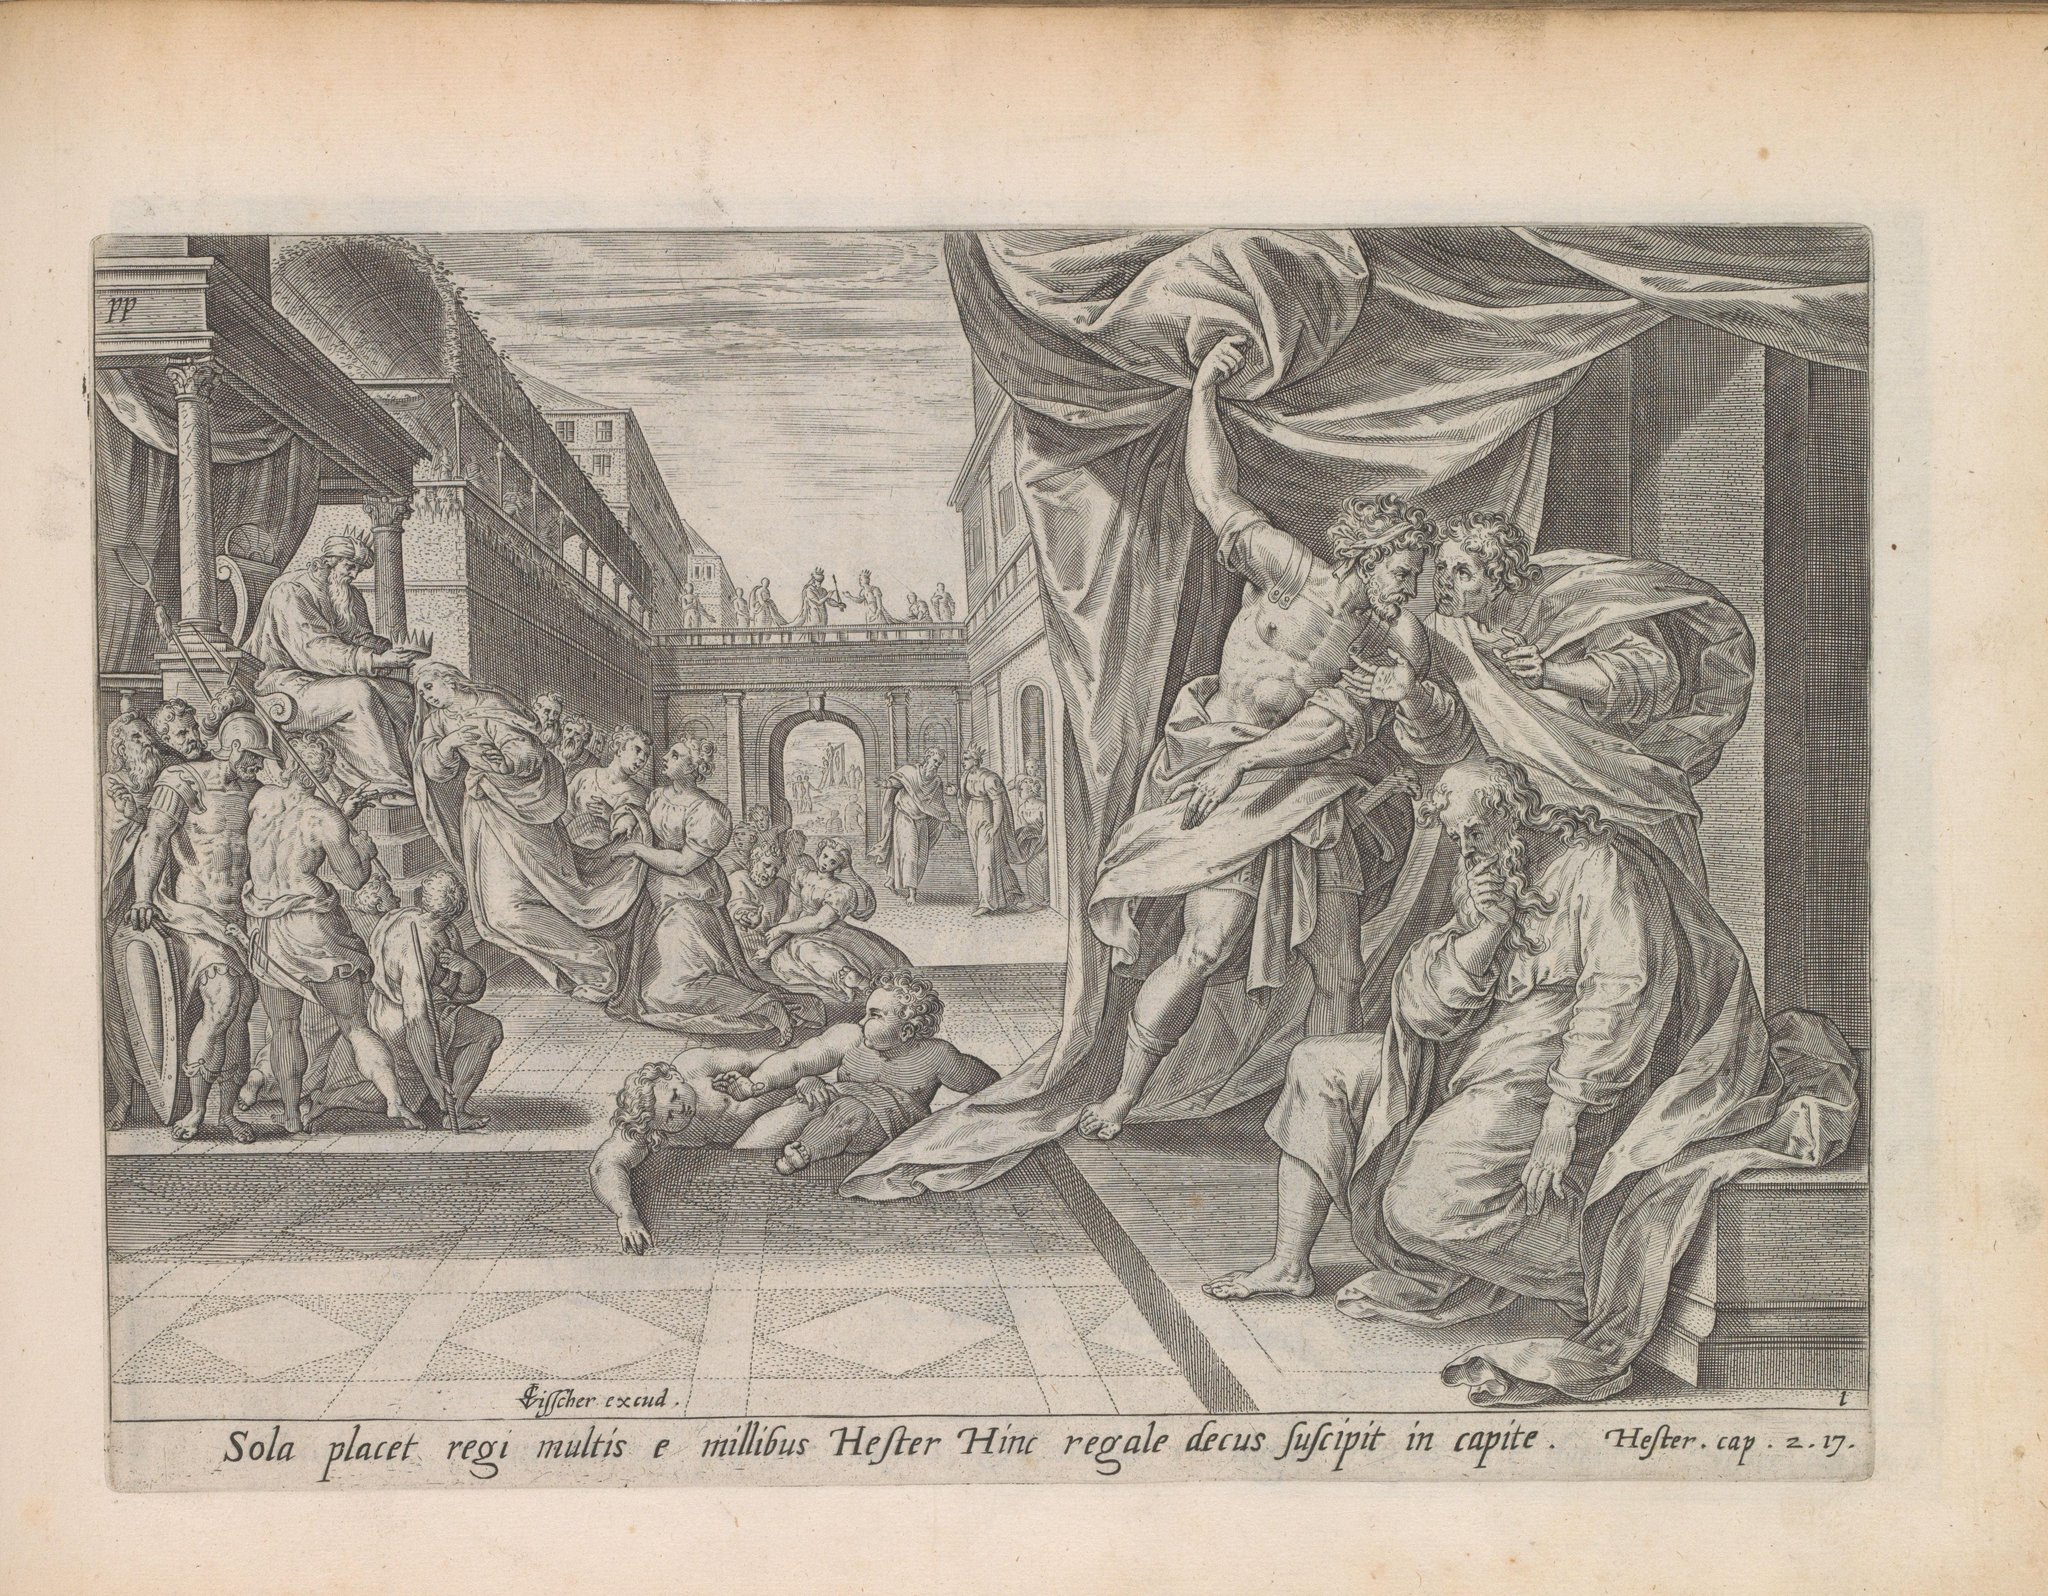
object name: album leaf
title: Theatrum Biblicum Hoc Est Historiae Sacrae Veteris et Novi Testamenti Tabulis Aeneis Expressae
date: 1579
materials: paper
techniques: engraving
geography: amsterdam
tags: crowning of esther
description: Ester wordt links door koning Ahasveros tot koningin gekroond. Op de voorgrond kijken drie mannen toe, waarschijnlijk is de middelste man Esters pleegvader Mordechai, die vraagt hoe het met Ester gaat. Op de achtergrond is te zien hoe Ester naar de koning wordt geleid. Onder de voorstelling een verwijzing in het Latijn naar de Bijbeltekst in Est. 2:17. Deze prent maakt deel uit van een album.